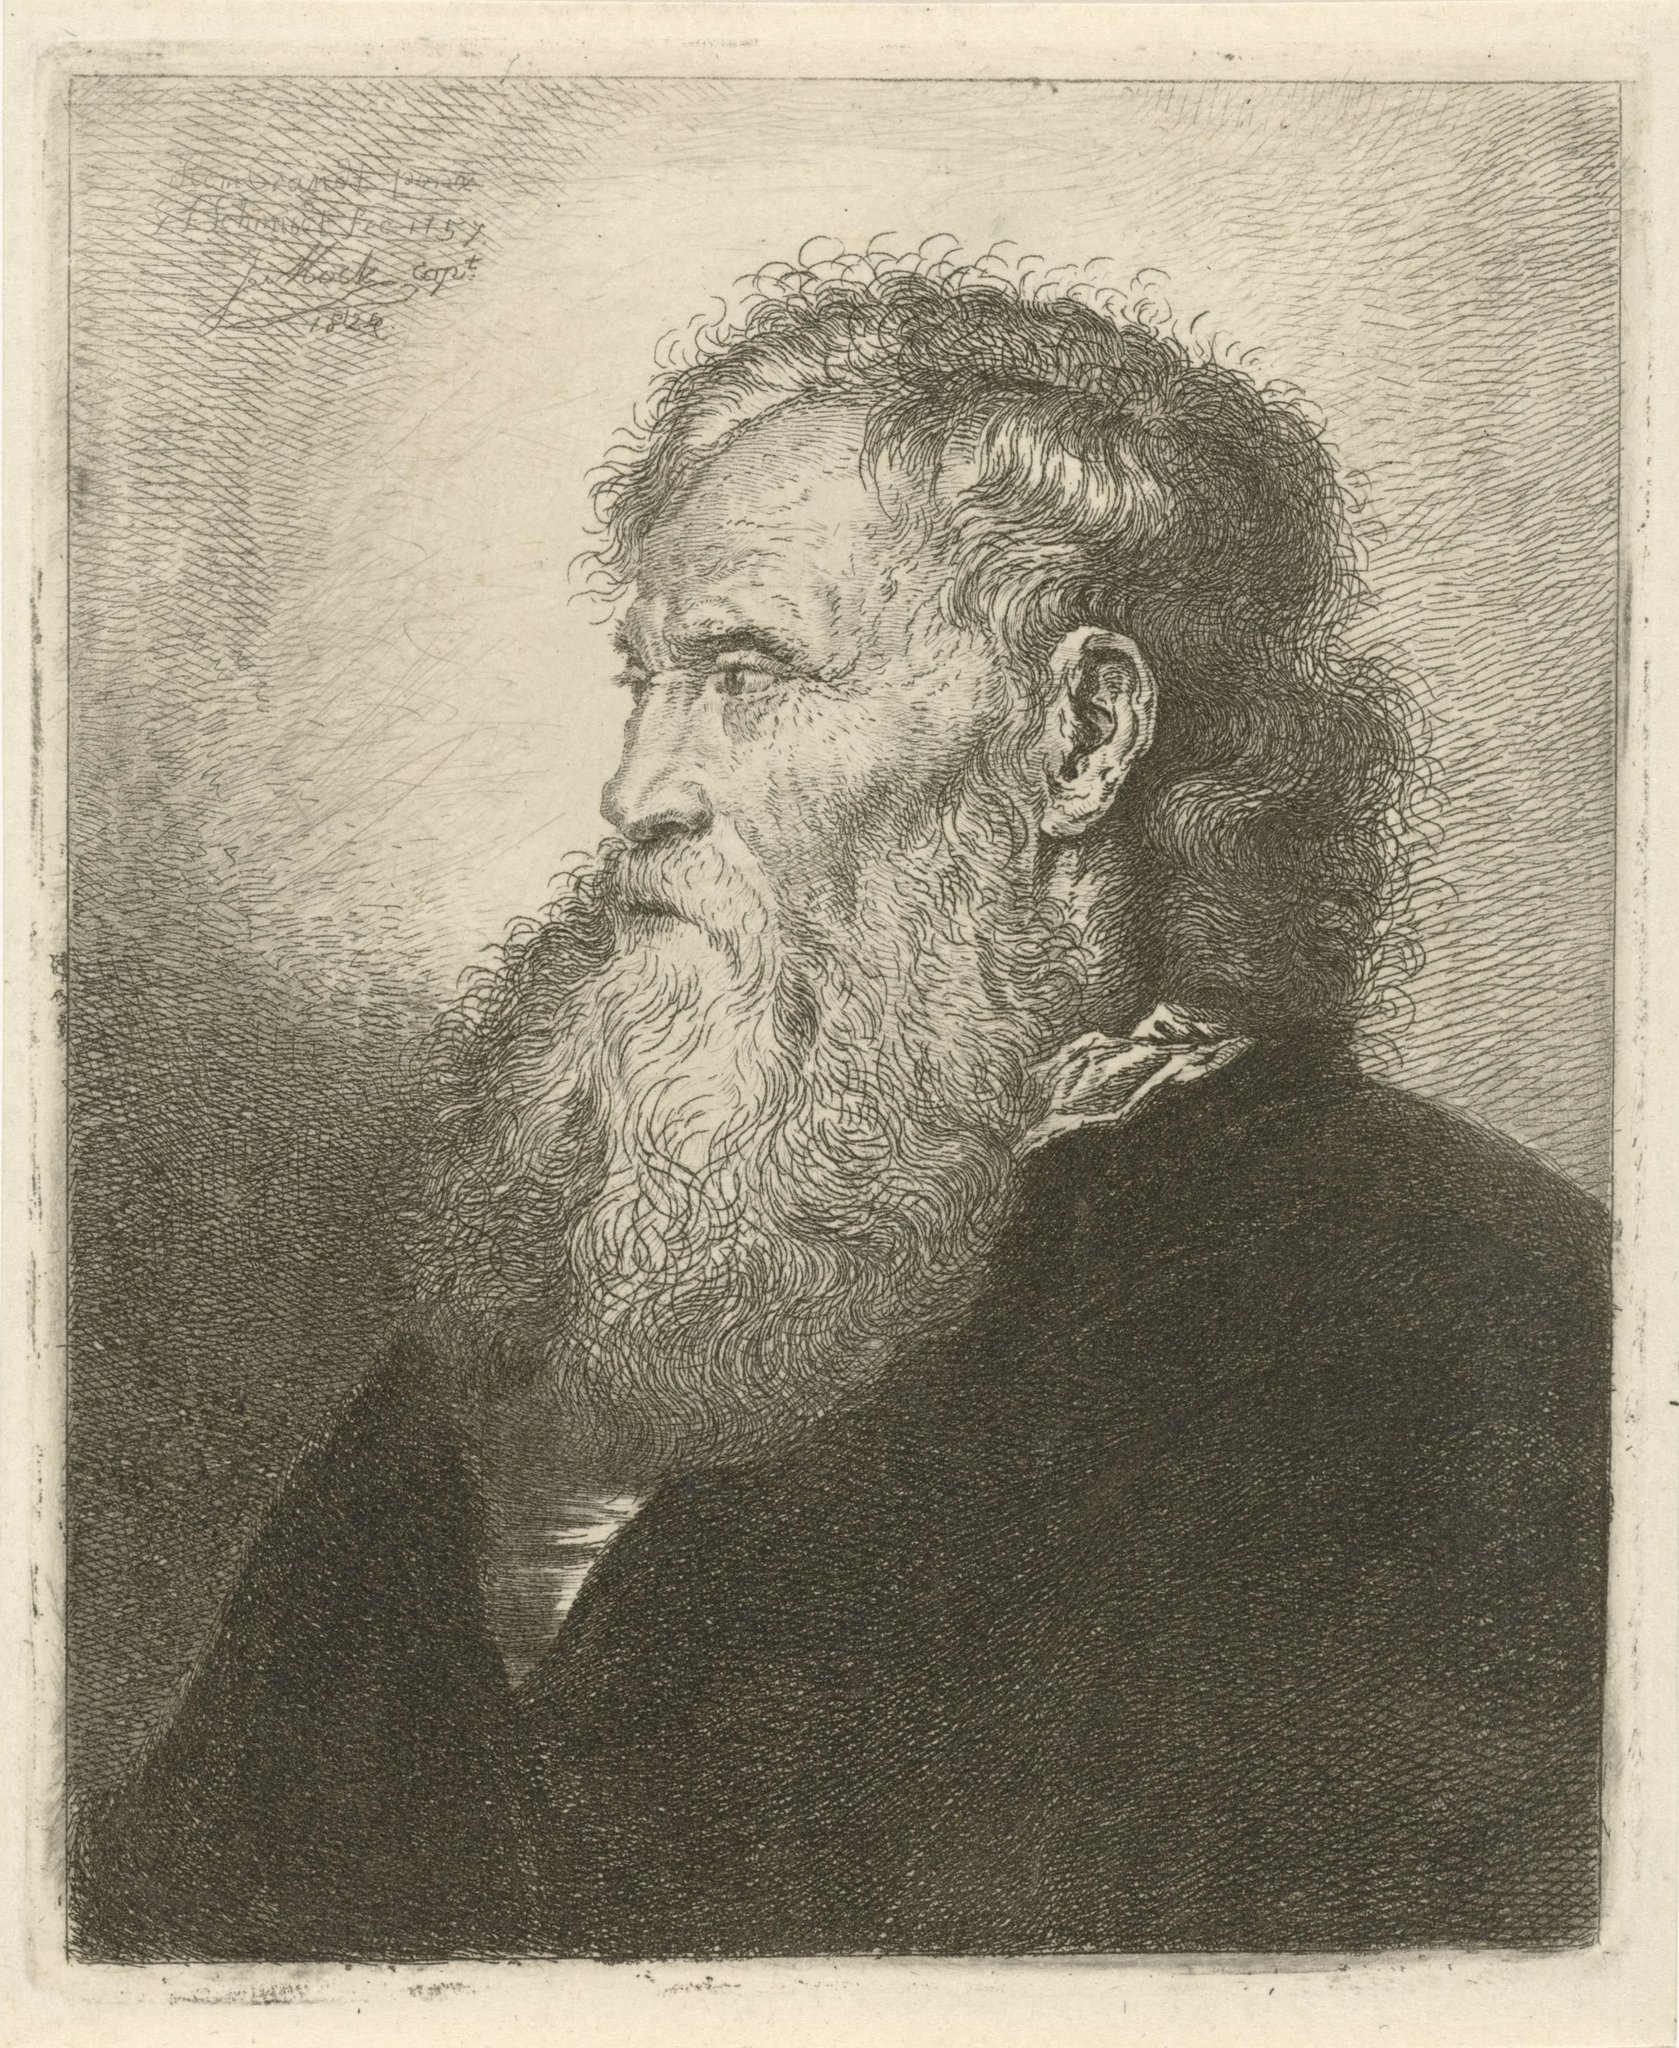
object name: print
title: Portret van een oude man met baard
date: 1824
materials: paper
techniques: aquatint, etching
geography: netherlands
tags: old man, beard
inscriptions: collector's mark: Lugt 2228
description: Portret van een oude man met baard, gekleed in een jas.